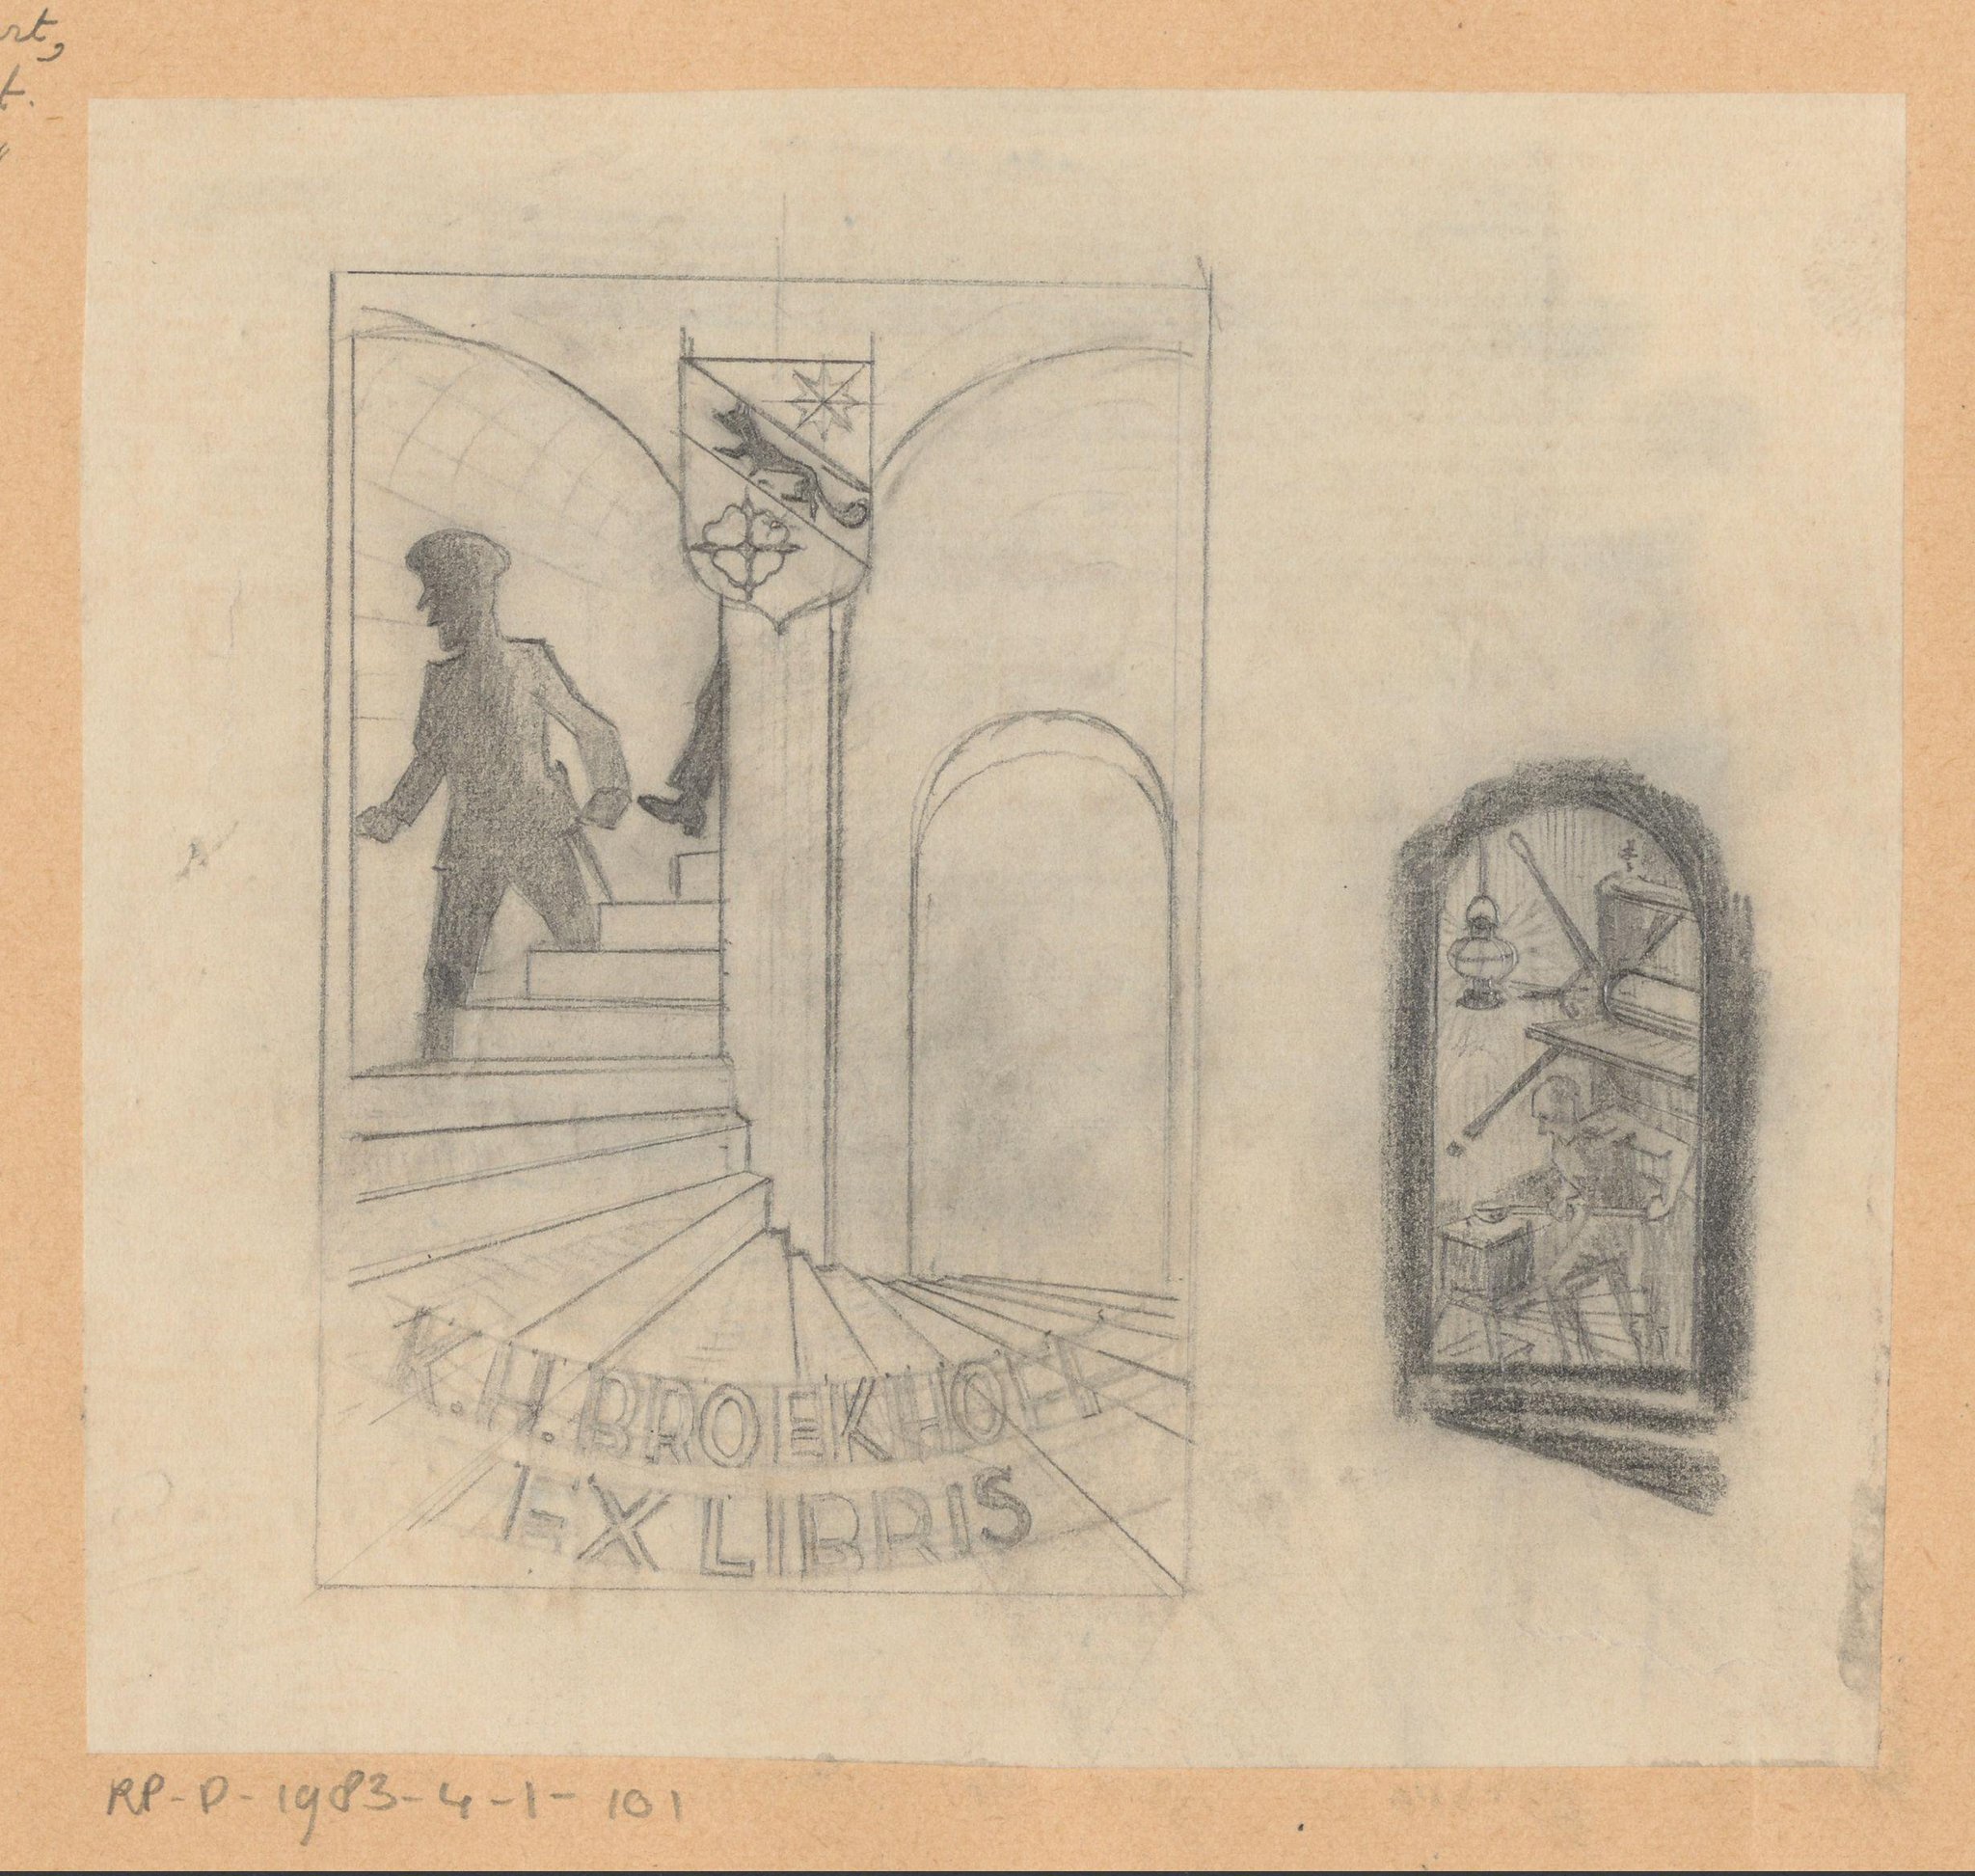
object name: design drawing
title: Ontwerptekenings voor ex libris van Karel Henri Broekhoff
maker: otto verhagen (i)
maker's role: draughtsman, print maker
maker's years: 1885-1951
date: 1934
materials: paper, pencil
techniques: drawing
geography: netherlands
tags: amsterdam, coin, armorial bearing, heraldry, cellar, police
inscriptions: inscription: ‘Clichédruk 1934.- De (...) Spreuk: Geen valschheid"’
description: Eigenaar van het ex libris was hoofdcommissaris van de politie in Amsterdam en belast met de bestrijding van valsmunterij. Voorstelling stelt het gezag (de politie) voor, die afdaalt naar het duister, de plaats waar misdrijf tiert. De politie werpt zijn schaduw vooruit.